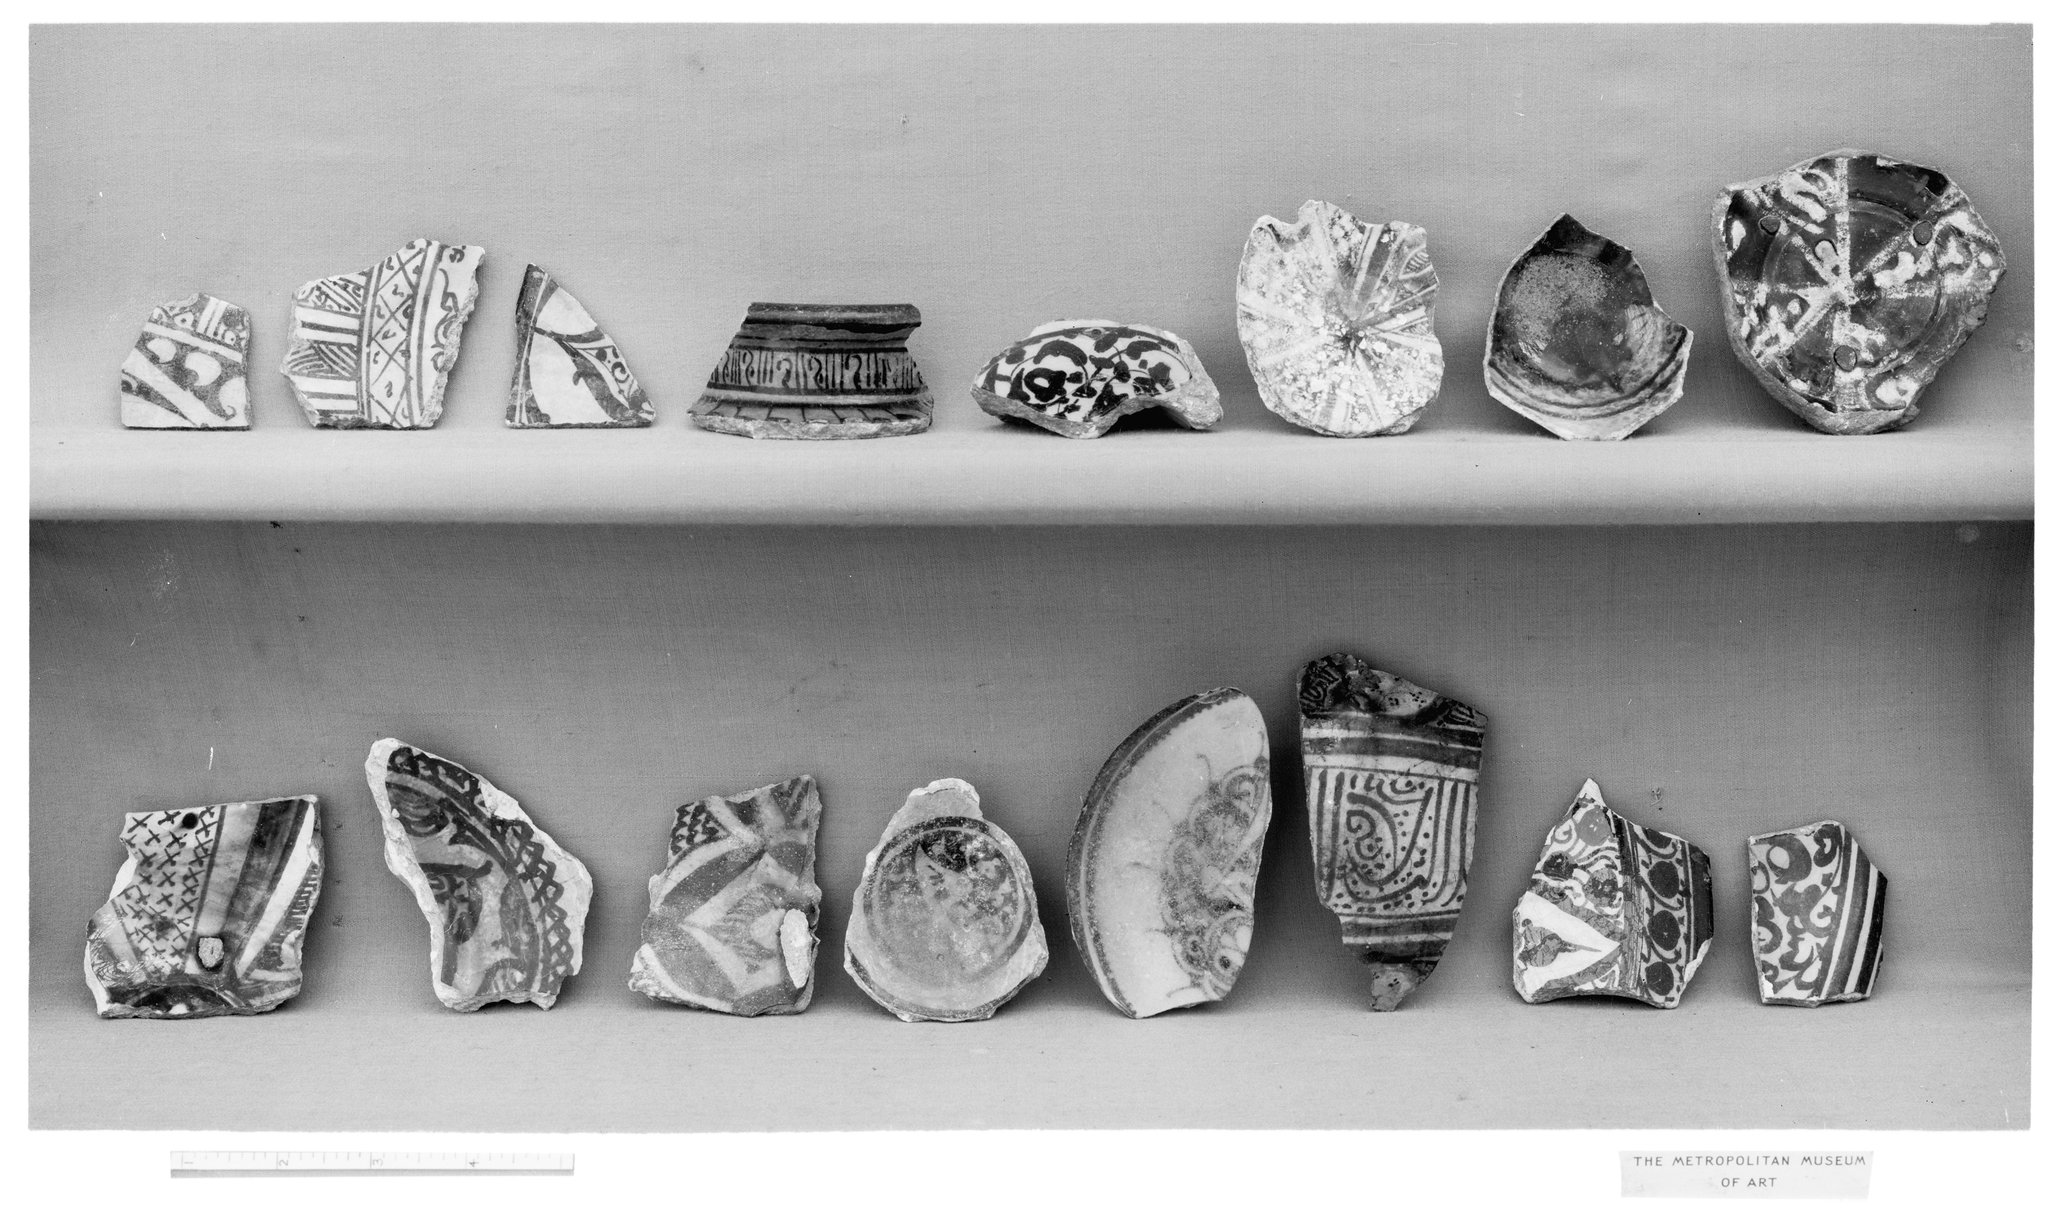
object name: fragment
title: Ceramic Fragment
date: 1201-1300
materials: stonepaste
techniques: painting, underglaze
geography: syria